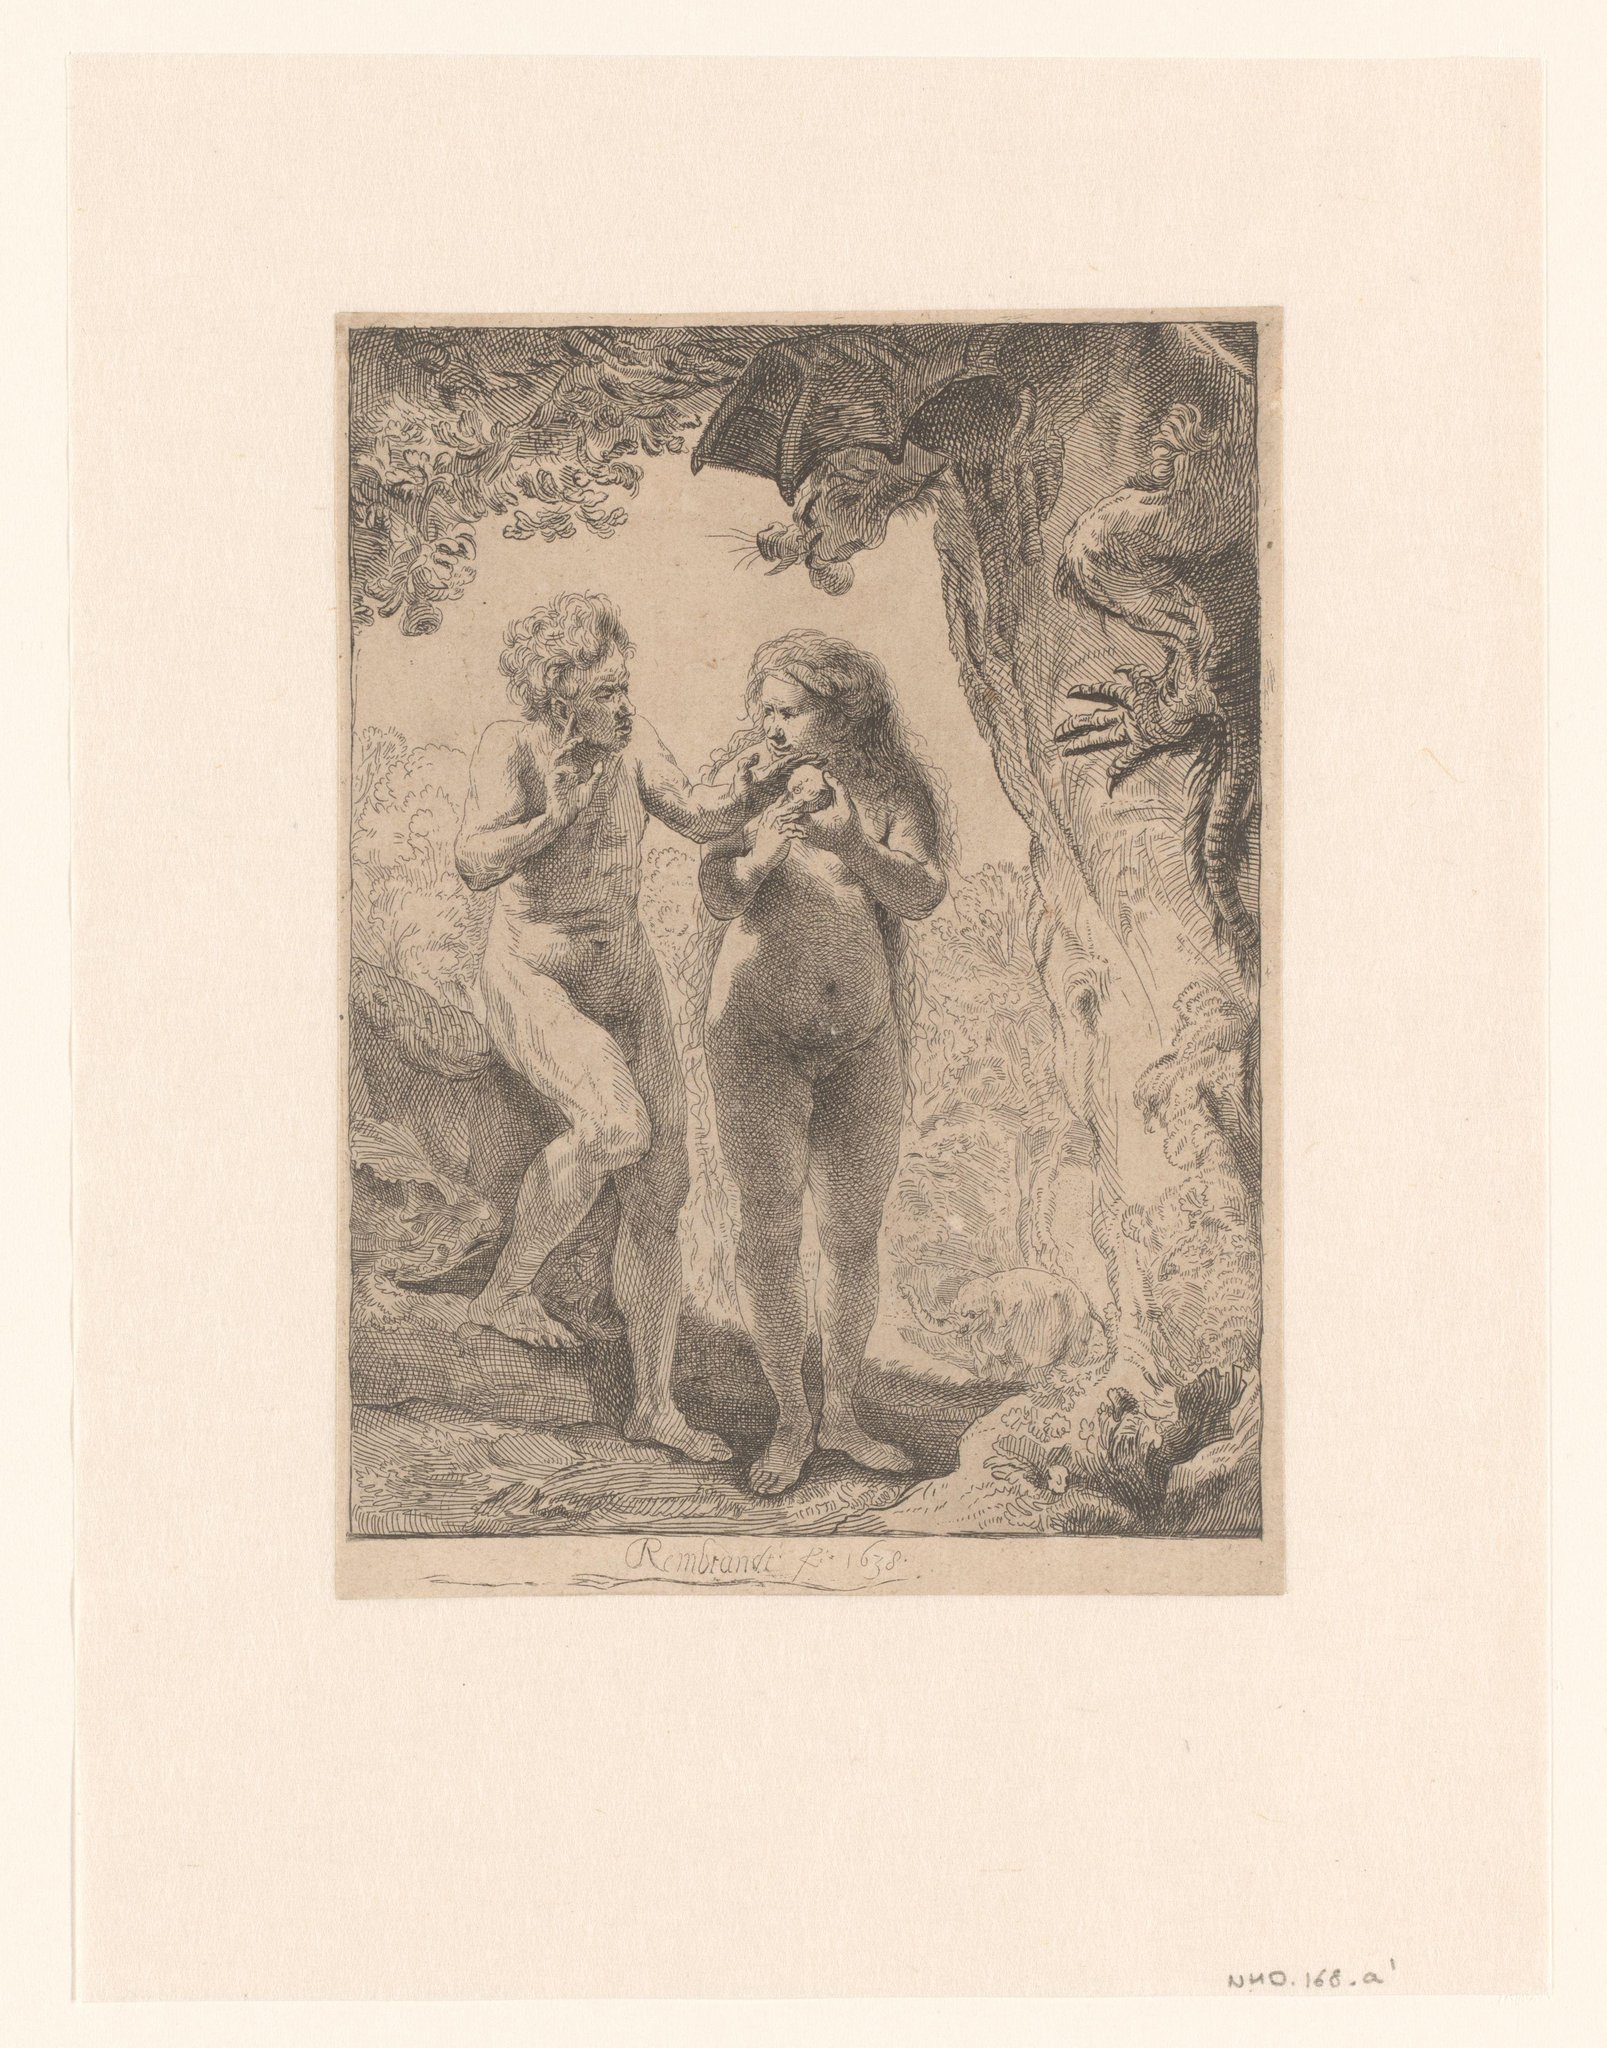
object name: print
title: Adam and Eve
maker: pierre françois basan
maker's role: print maker, publisher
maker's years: 1723-1797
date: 1733-1797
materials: paper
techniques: etching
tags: temptation and fall (genesis 3:1-7)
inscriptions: collector's mark: Lugt 2760, collector's mark: Lugt 2228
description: Spiegelbeeldige kopie naar de gelijknamige prent van Rembrandt.